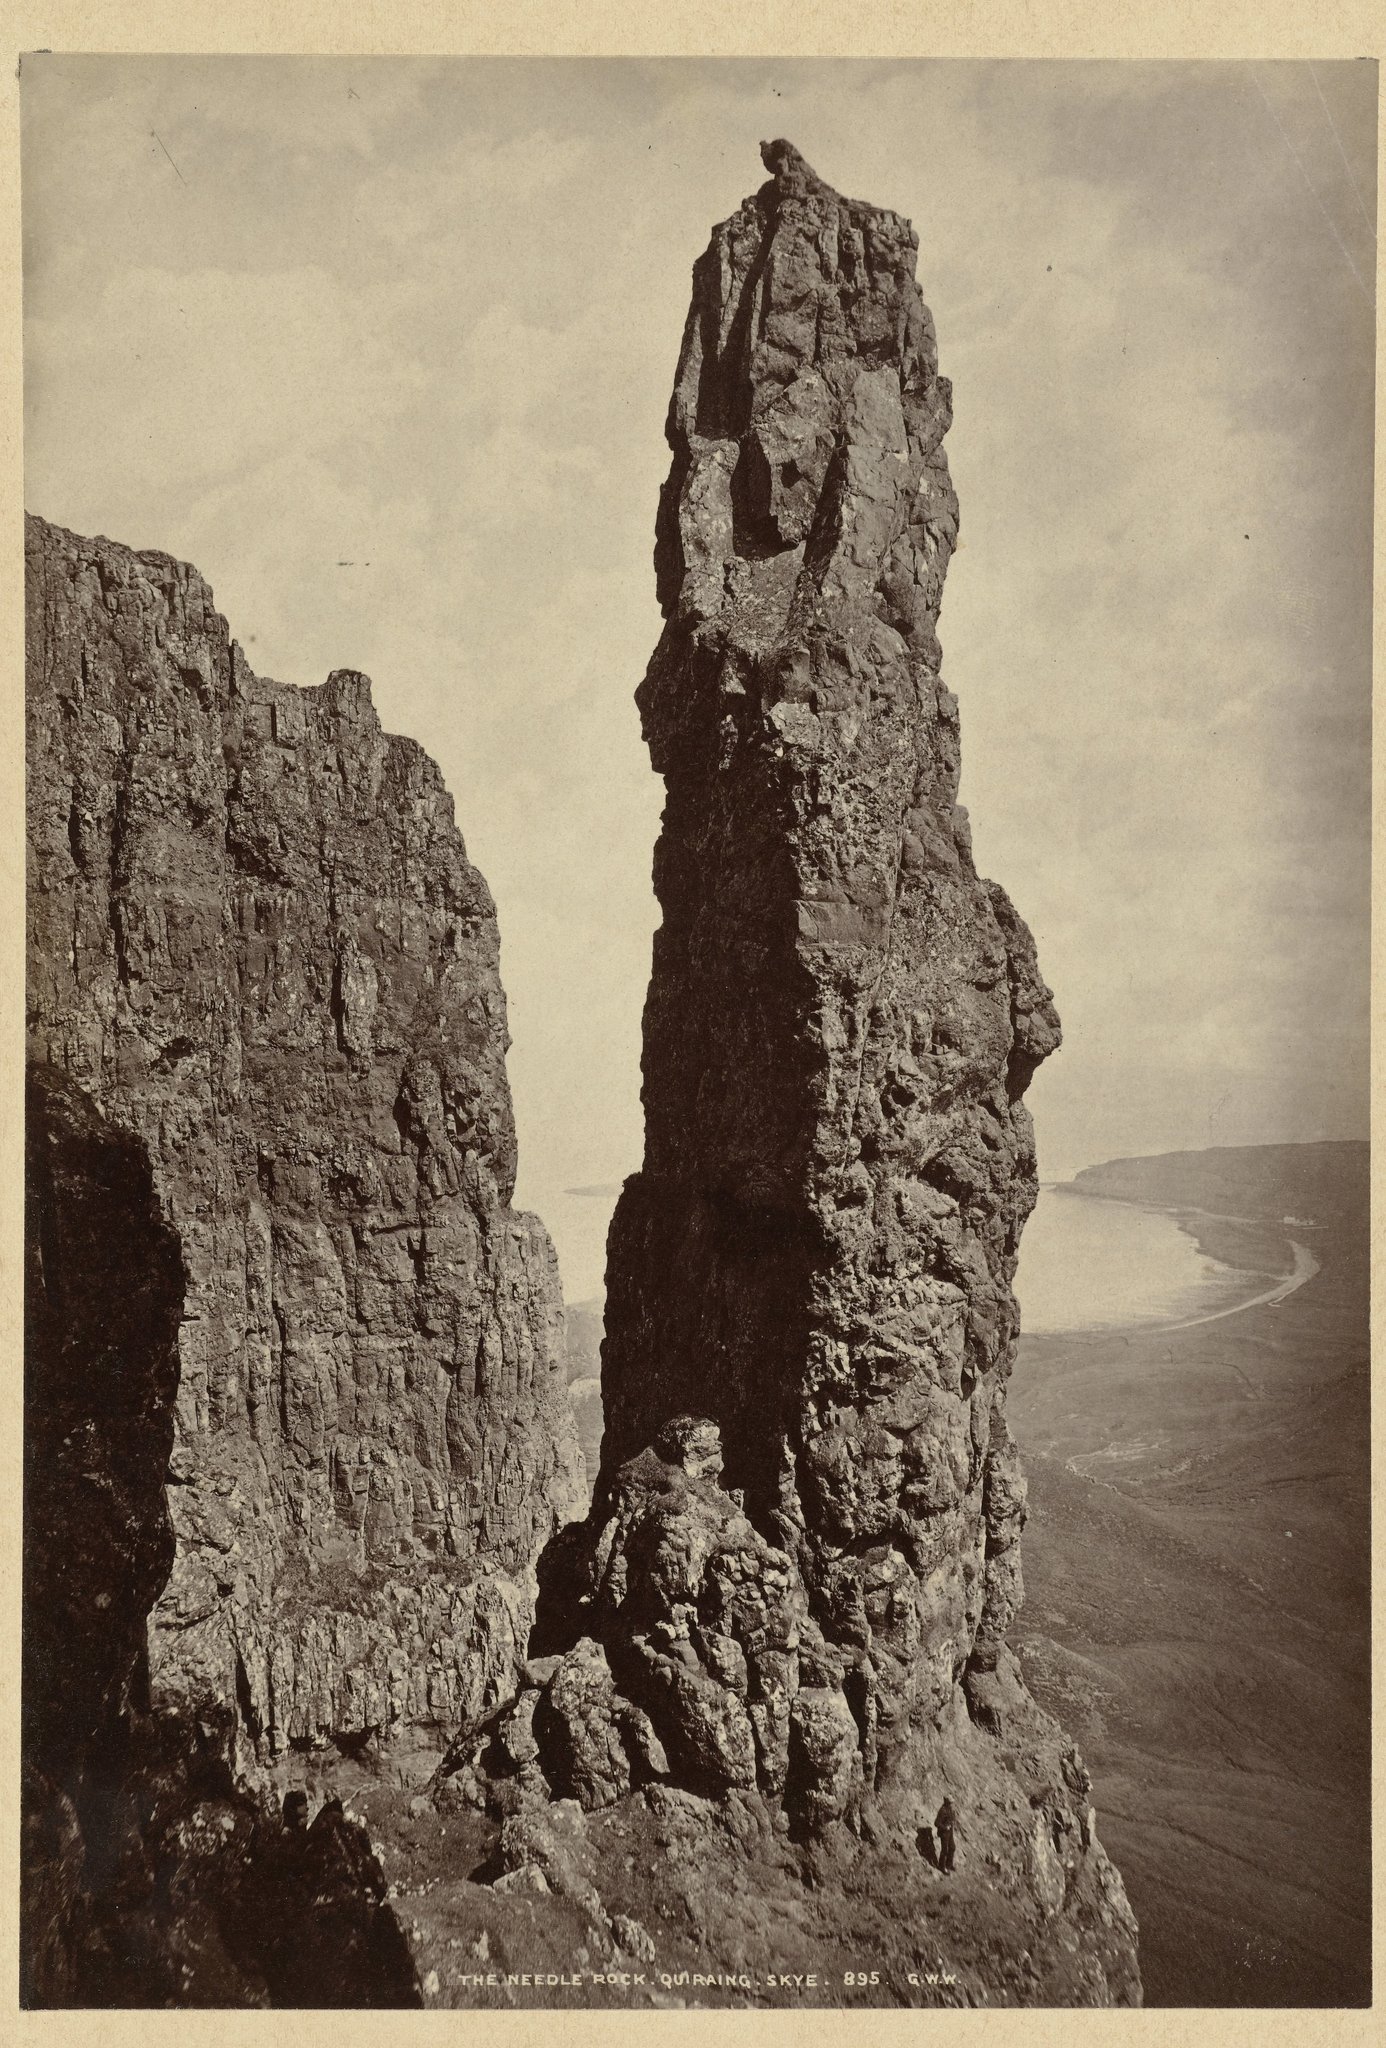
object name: photograph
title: Needle Rock op de Quiraing op Skye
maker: george washington wilson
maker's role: publisher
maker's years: 1823-1893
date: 1860-1880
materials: cardboard, paper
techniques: albumen print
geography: skye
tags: rock-formations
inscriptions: number: ‘895.’